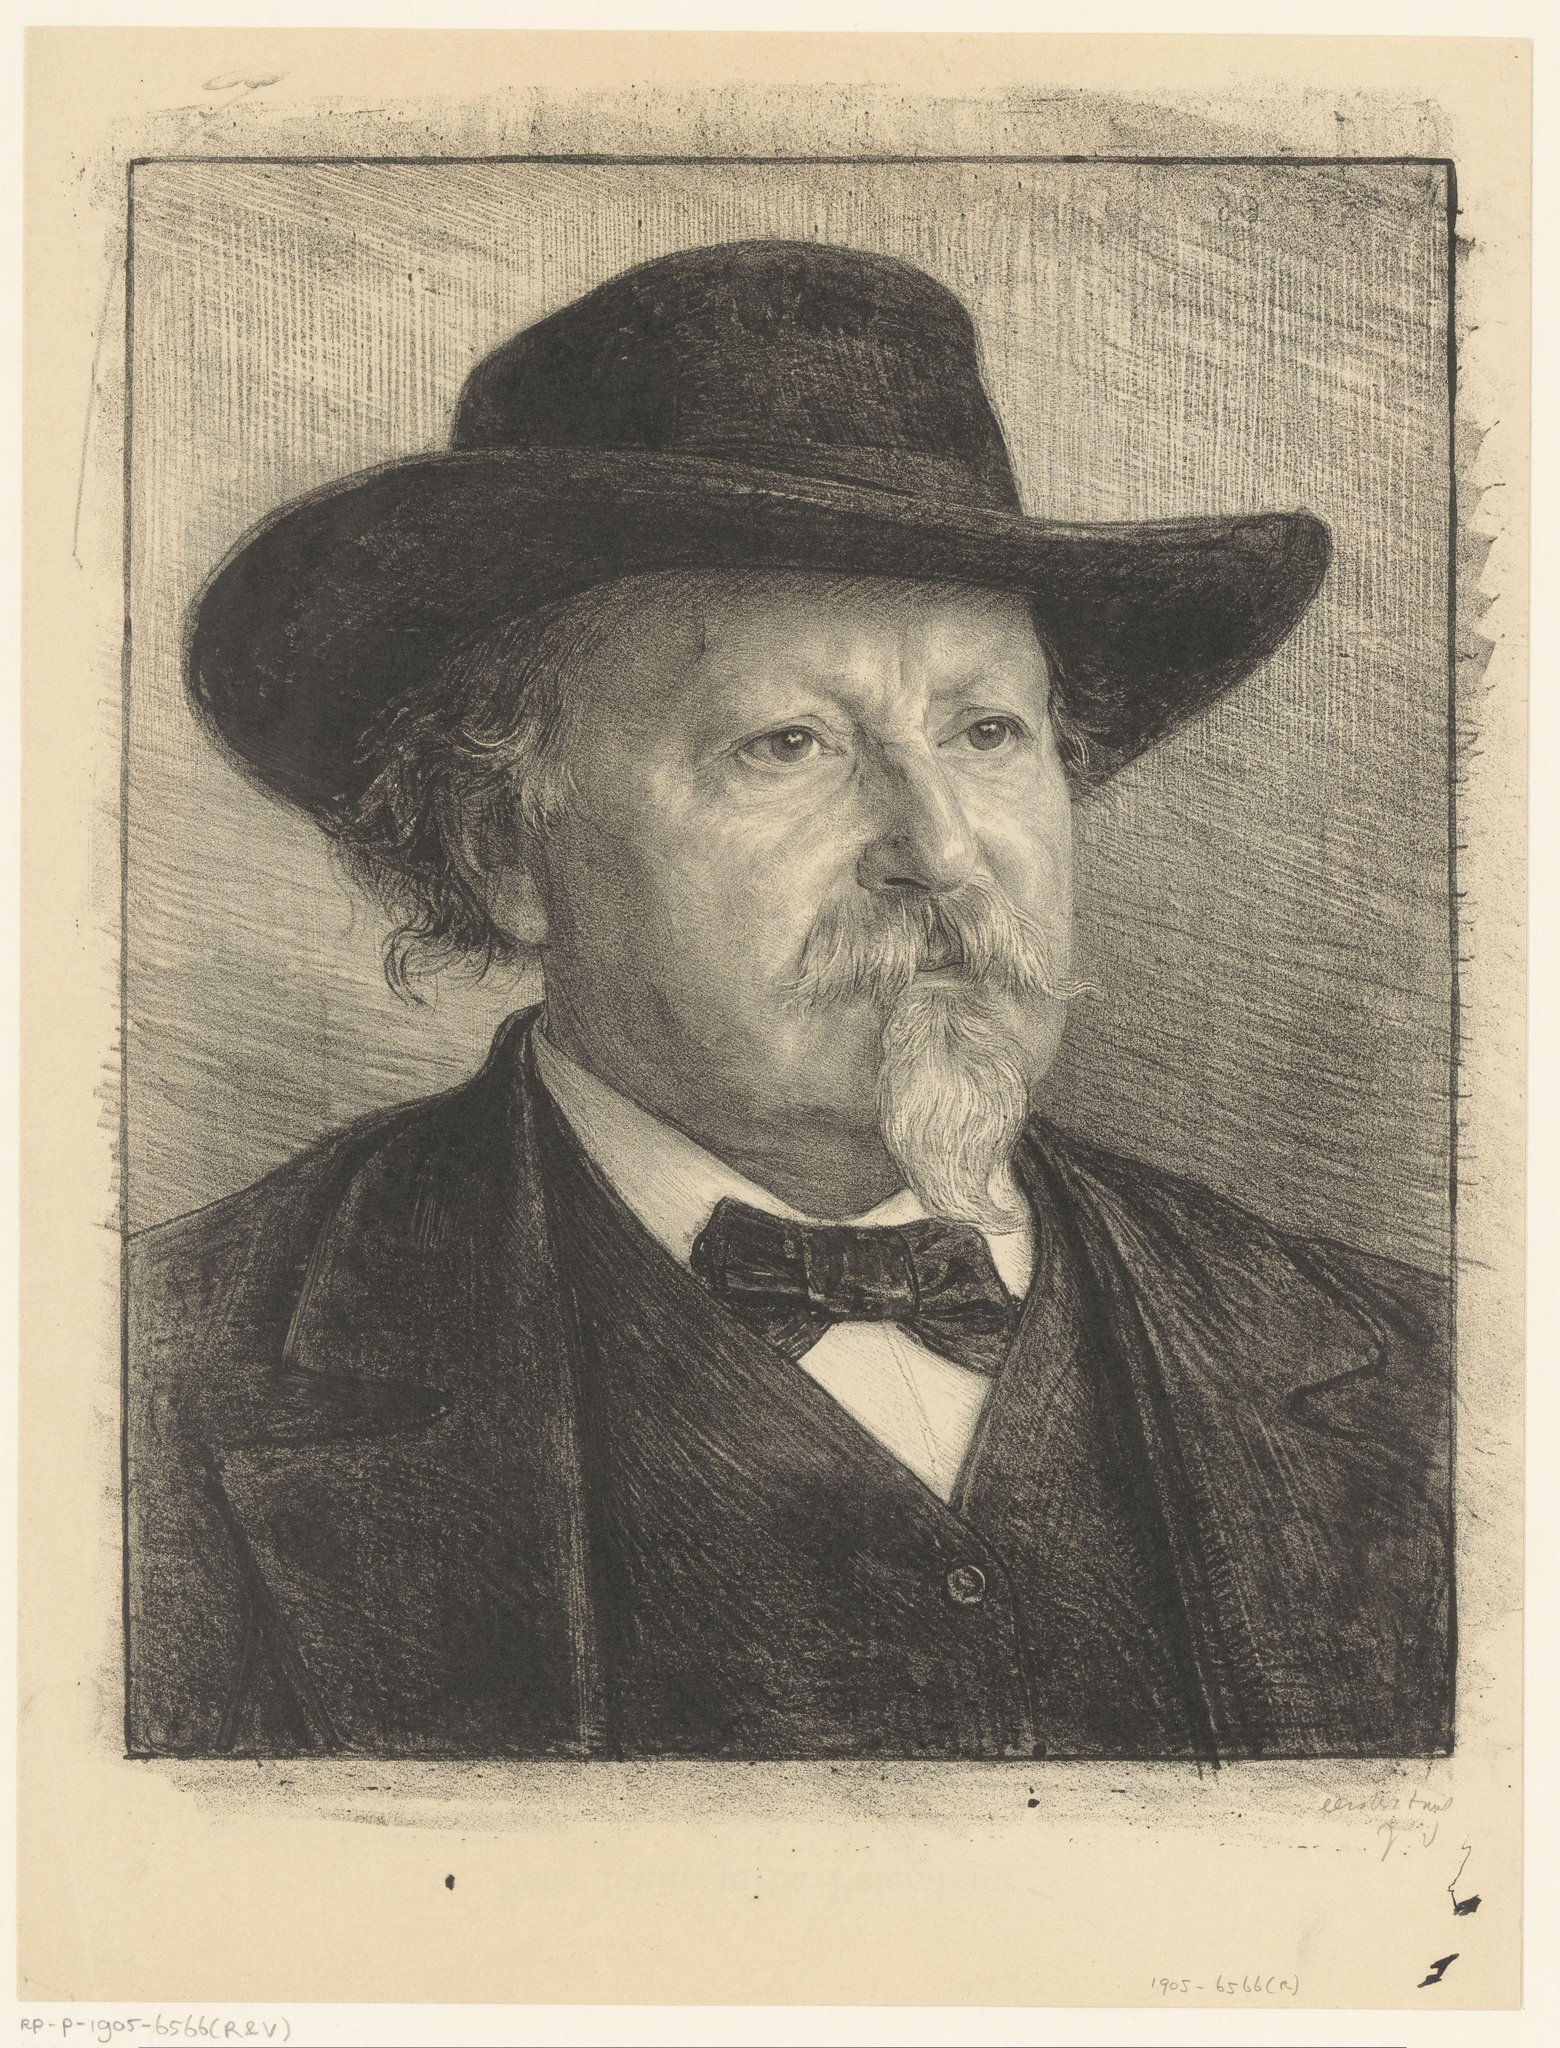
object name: print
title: Portret van Johan Philip van der Kellen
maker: jan veth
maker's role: designer, draughtsman, painter, print maker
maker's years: 1864-1925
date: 1897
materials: paper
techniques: lithograph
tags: utrecht, draughtsman, johan philip van der kellen, historical persons (+ (full) bust portrait)